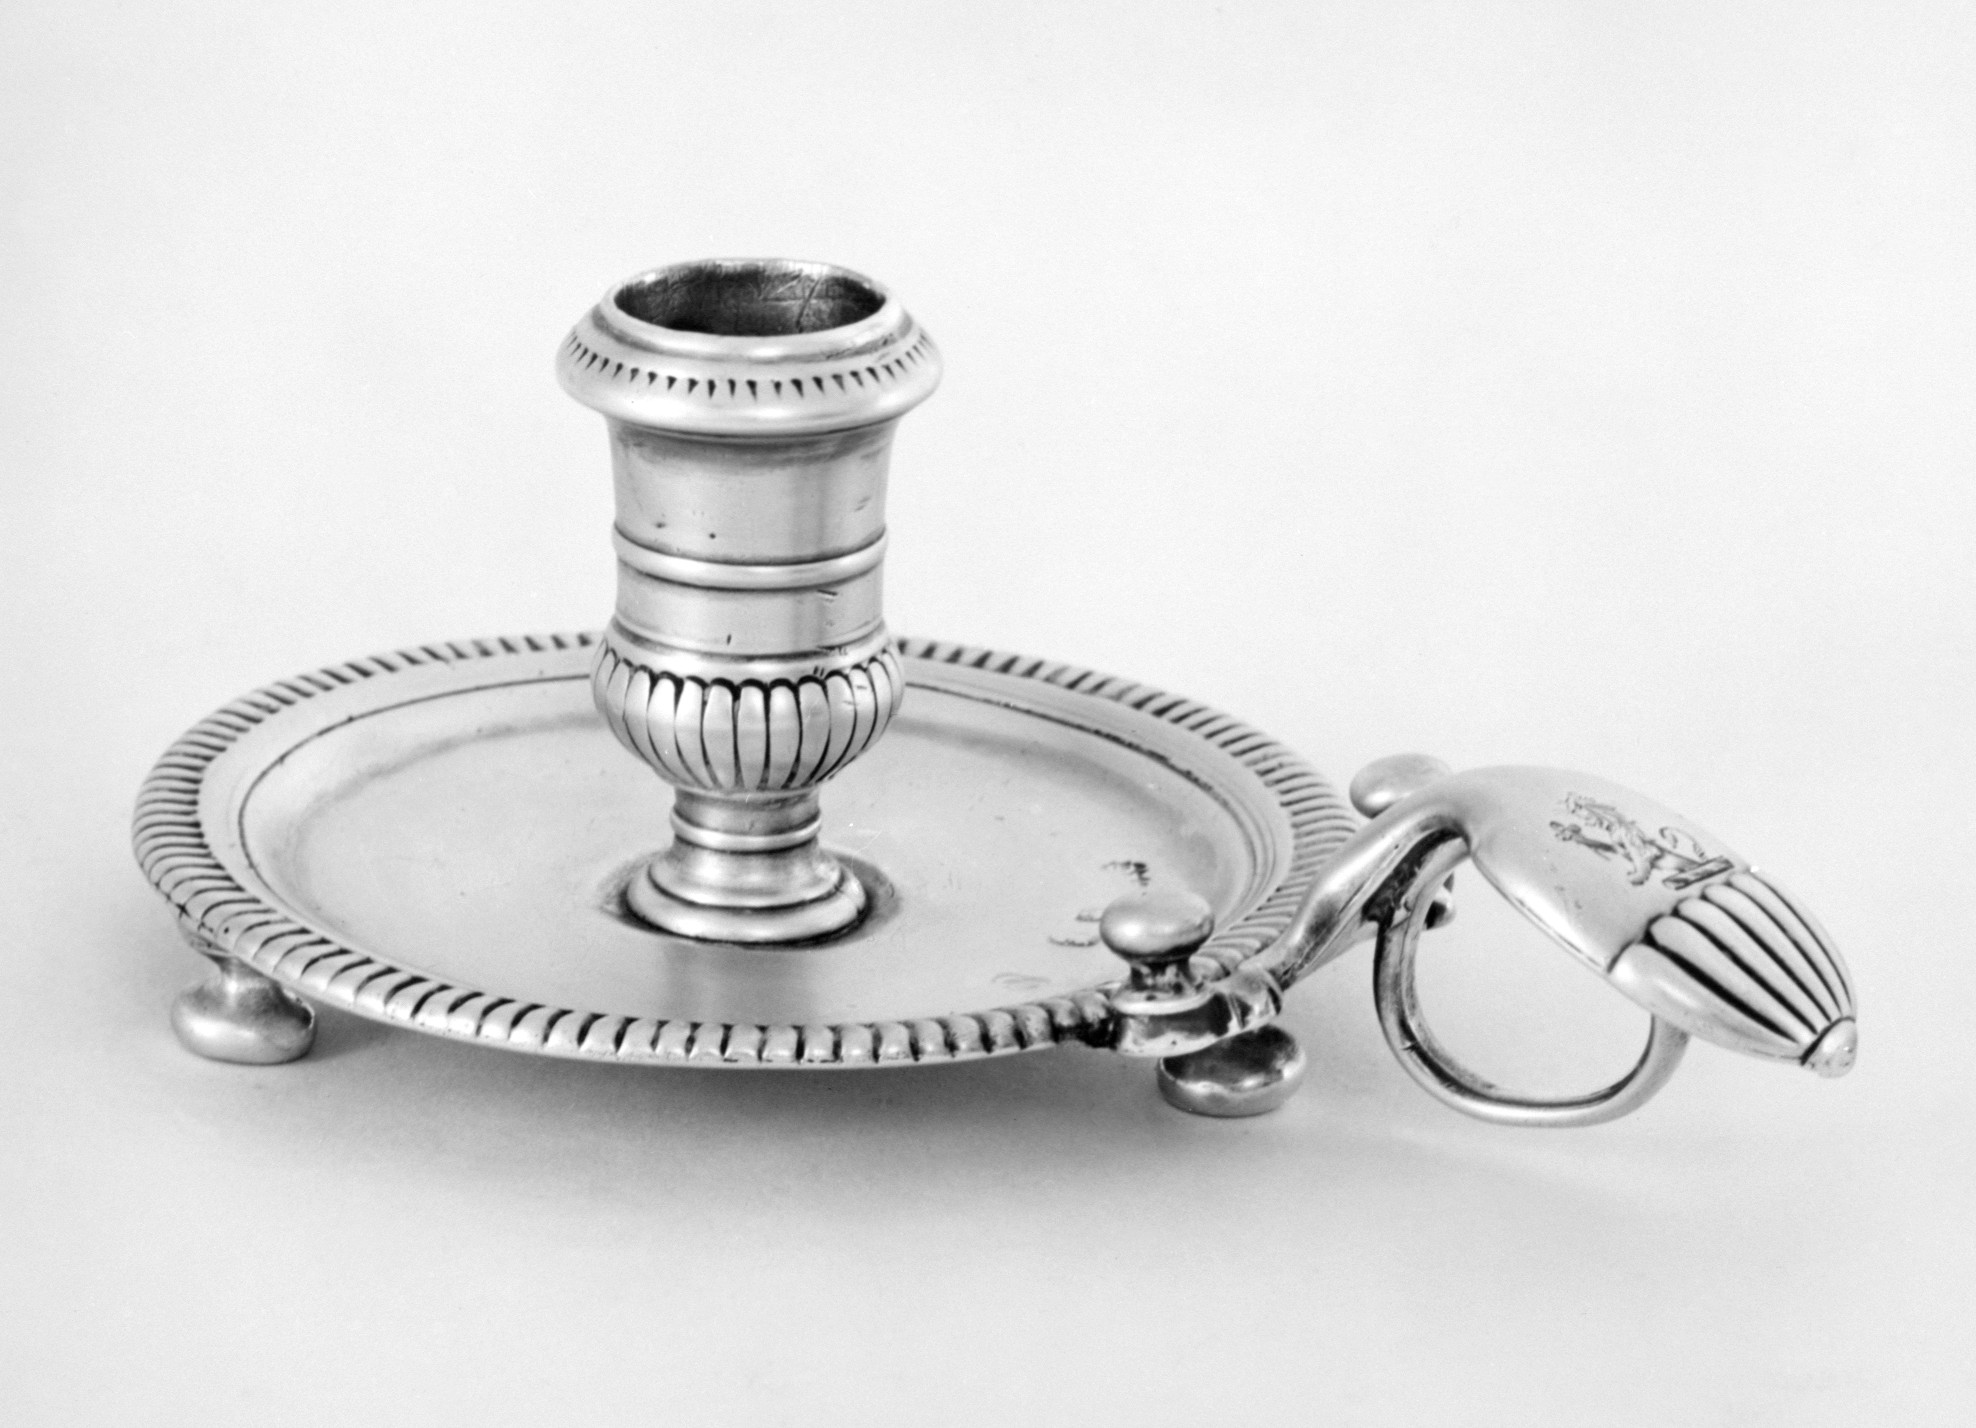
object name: chamberstick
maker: anthony nelme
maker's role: maker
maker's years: 1622-1722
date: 1699-1700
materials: silver